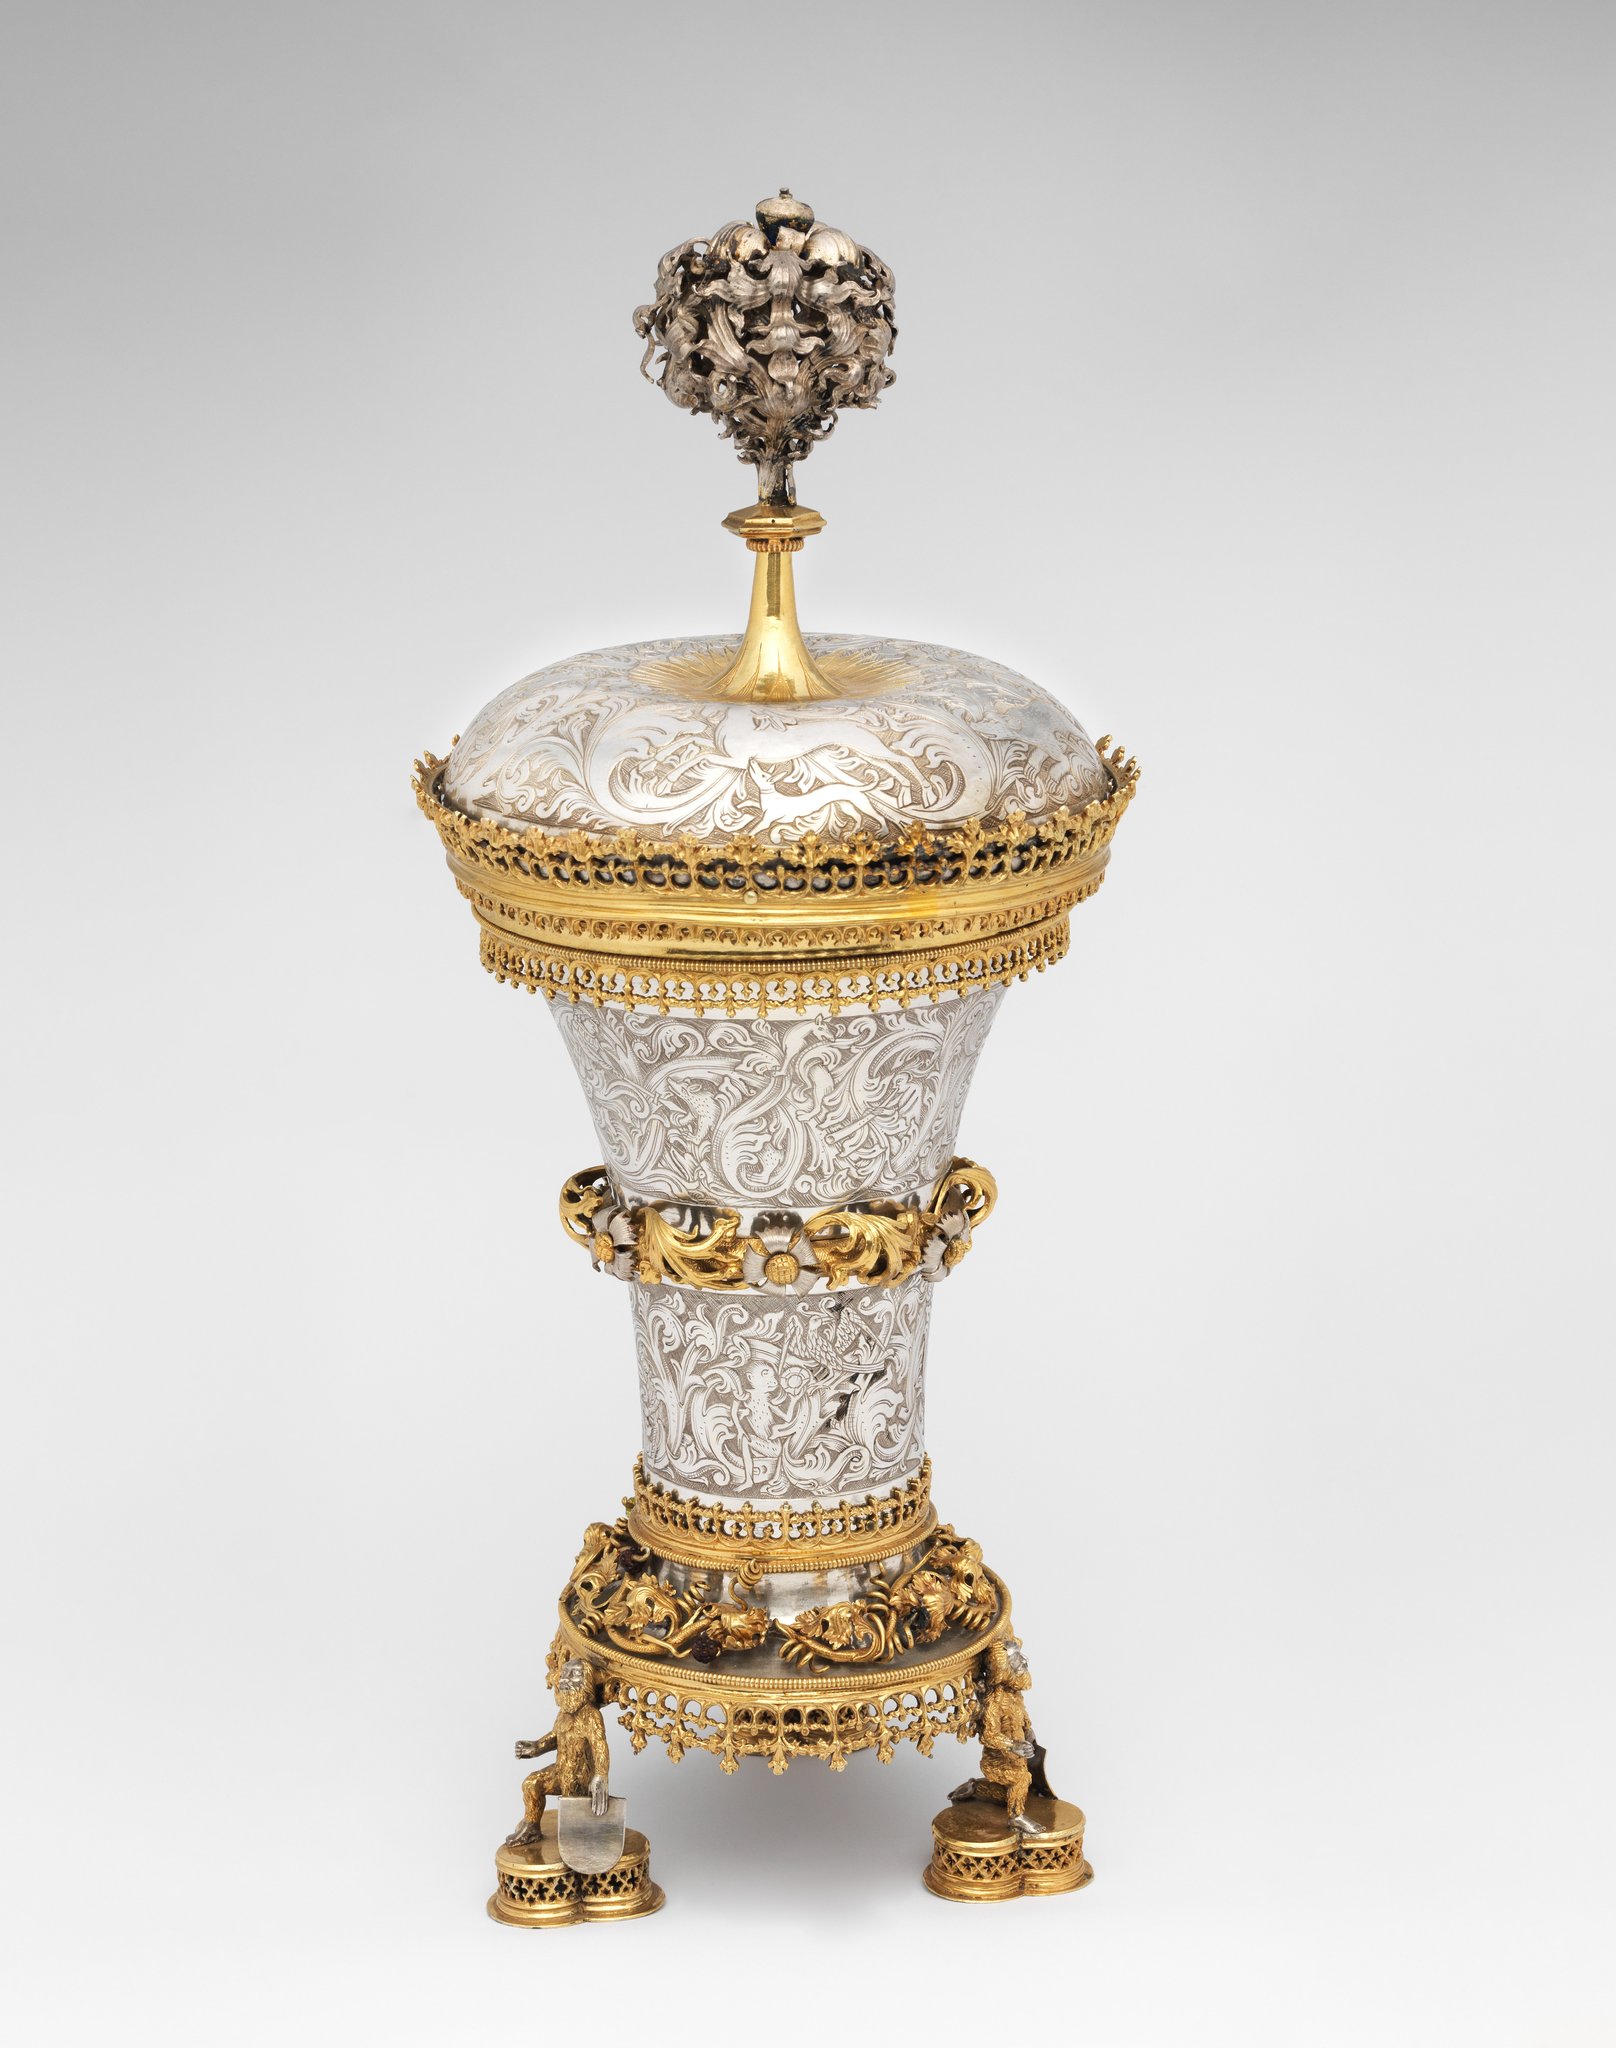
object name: beaker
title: Covered Beaker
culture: german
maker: hans greiff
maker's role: artist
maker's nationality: german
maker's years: 1470-1516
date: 1470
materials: enamel, gilt silver, glass, silver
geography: germany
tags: men,coat of arms